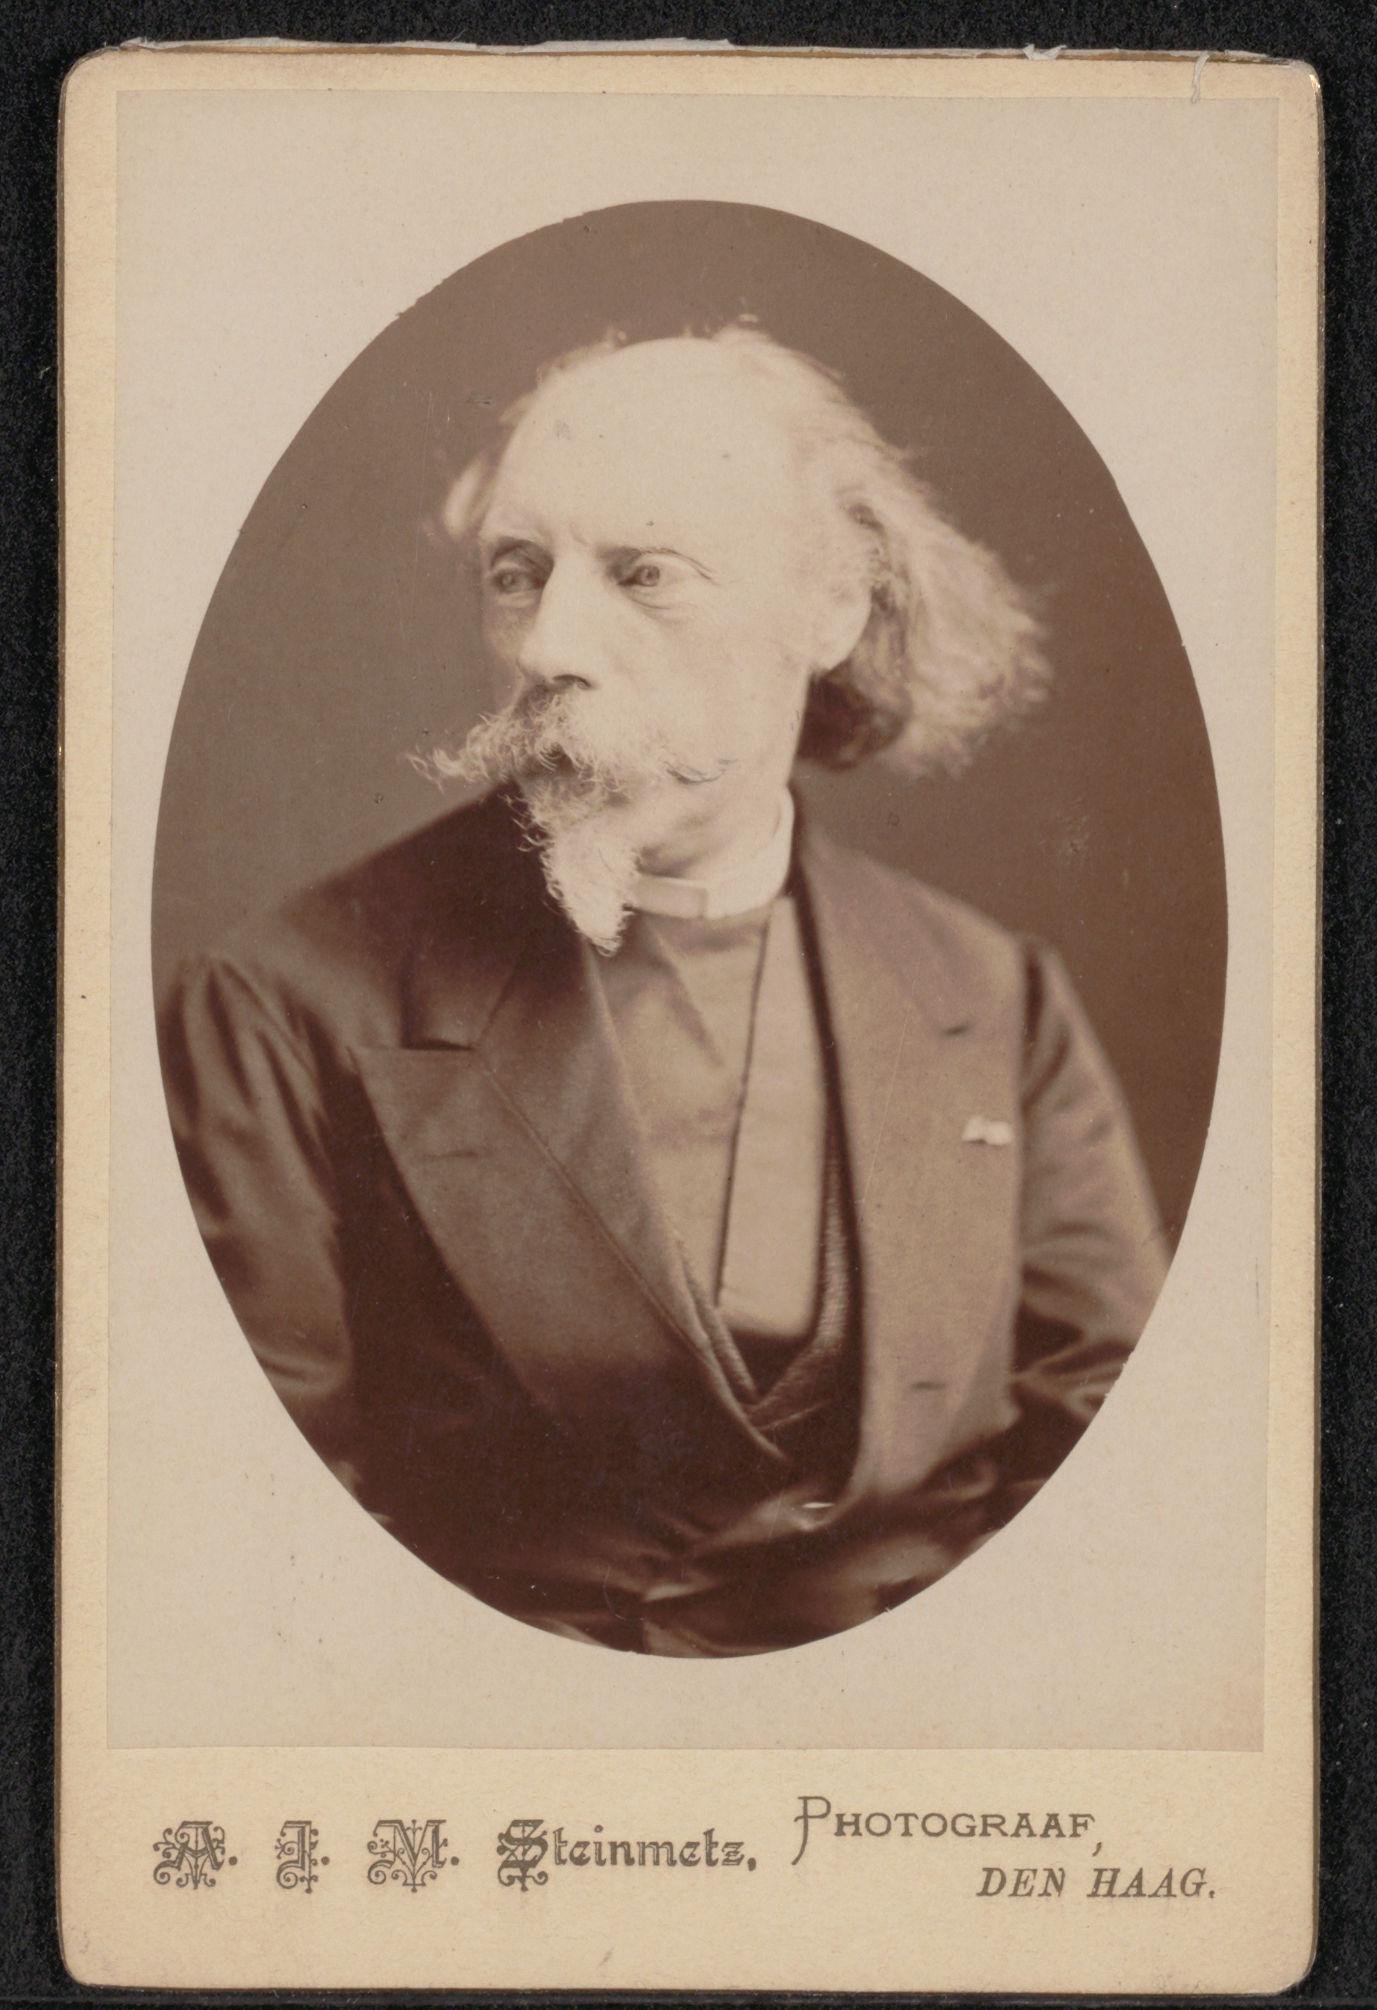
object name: photograph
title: Foto van Christoffel Bisschop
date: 1868-1904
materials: cardboard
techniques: albumen print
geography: the hague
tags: draughtsman, christoffel bisschop, historical persons (portraits and scenes from the life)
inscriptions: collector's mark: ‘RPK’